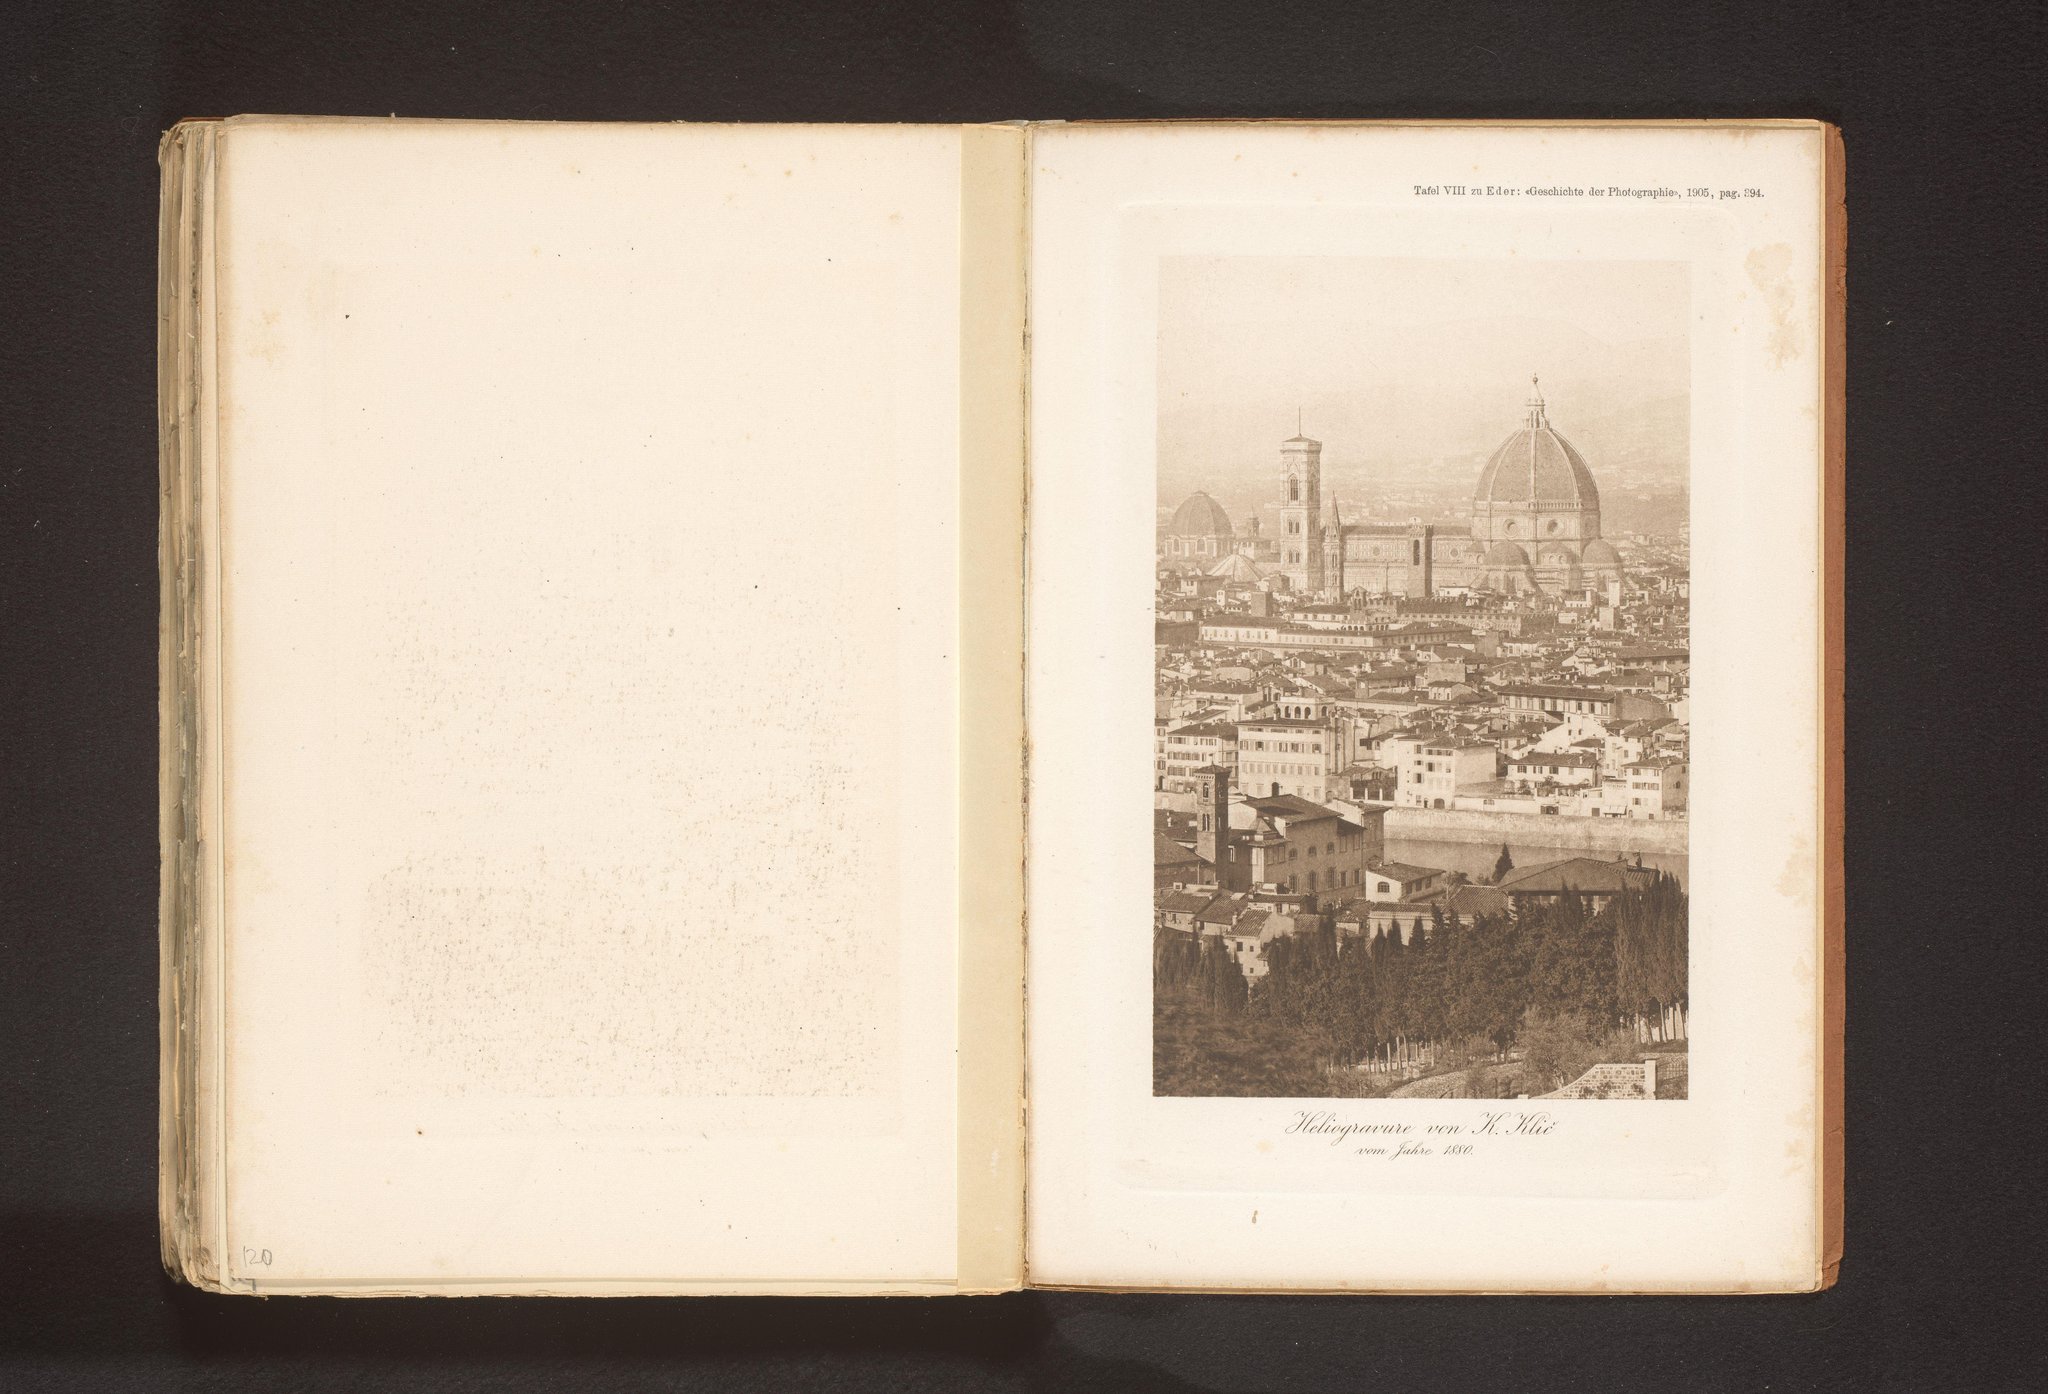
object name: page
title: Gezicht op Florence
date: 1900-1905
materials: paper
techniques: photoaquatint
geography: florence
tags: city-view in general; 'veduta'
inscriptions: number: ‘Tafel VIII’